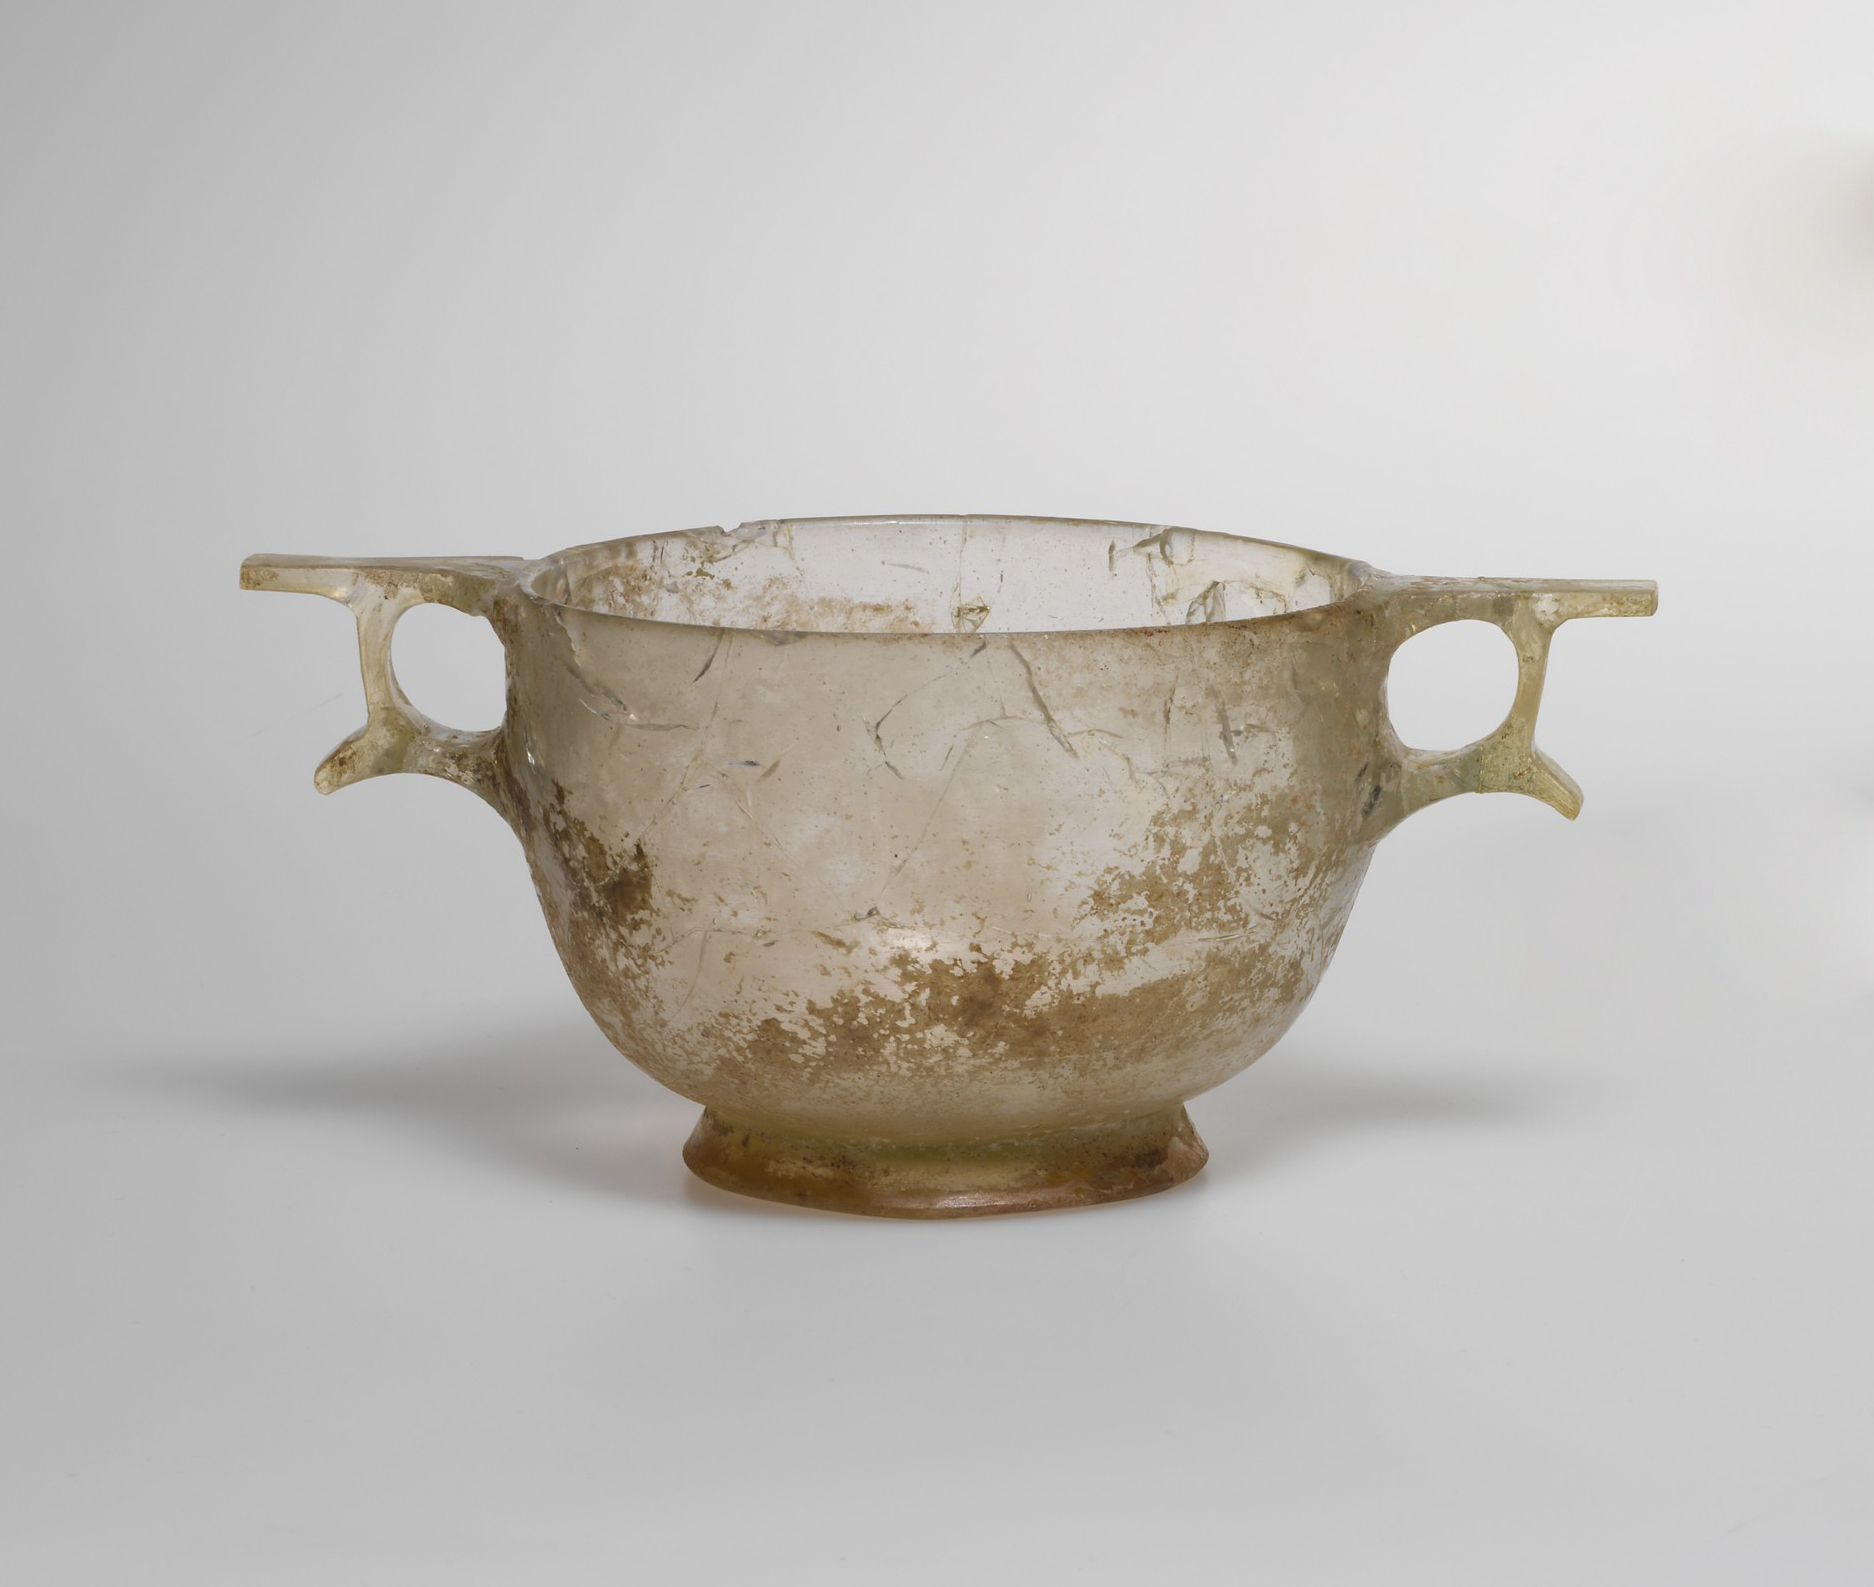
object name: skyphos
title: Glass skyphos (drinking cup)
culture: greek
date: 234-168 BCE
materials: glass